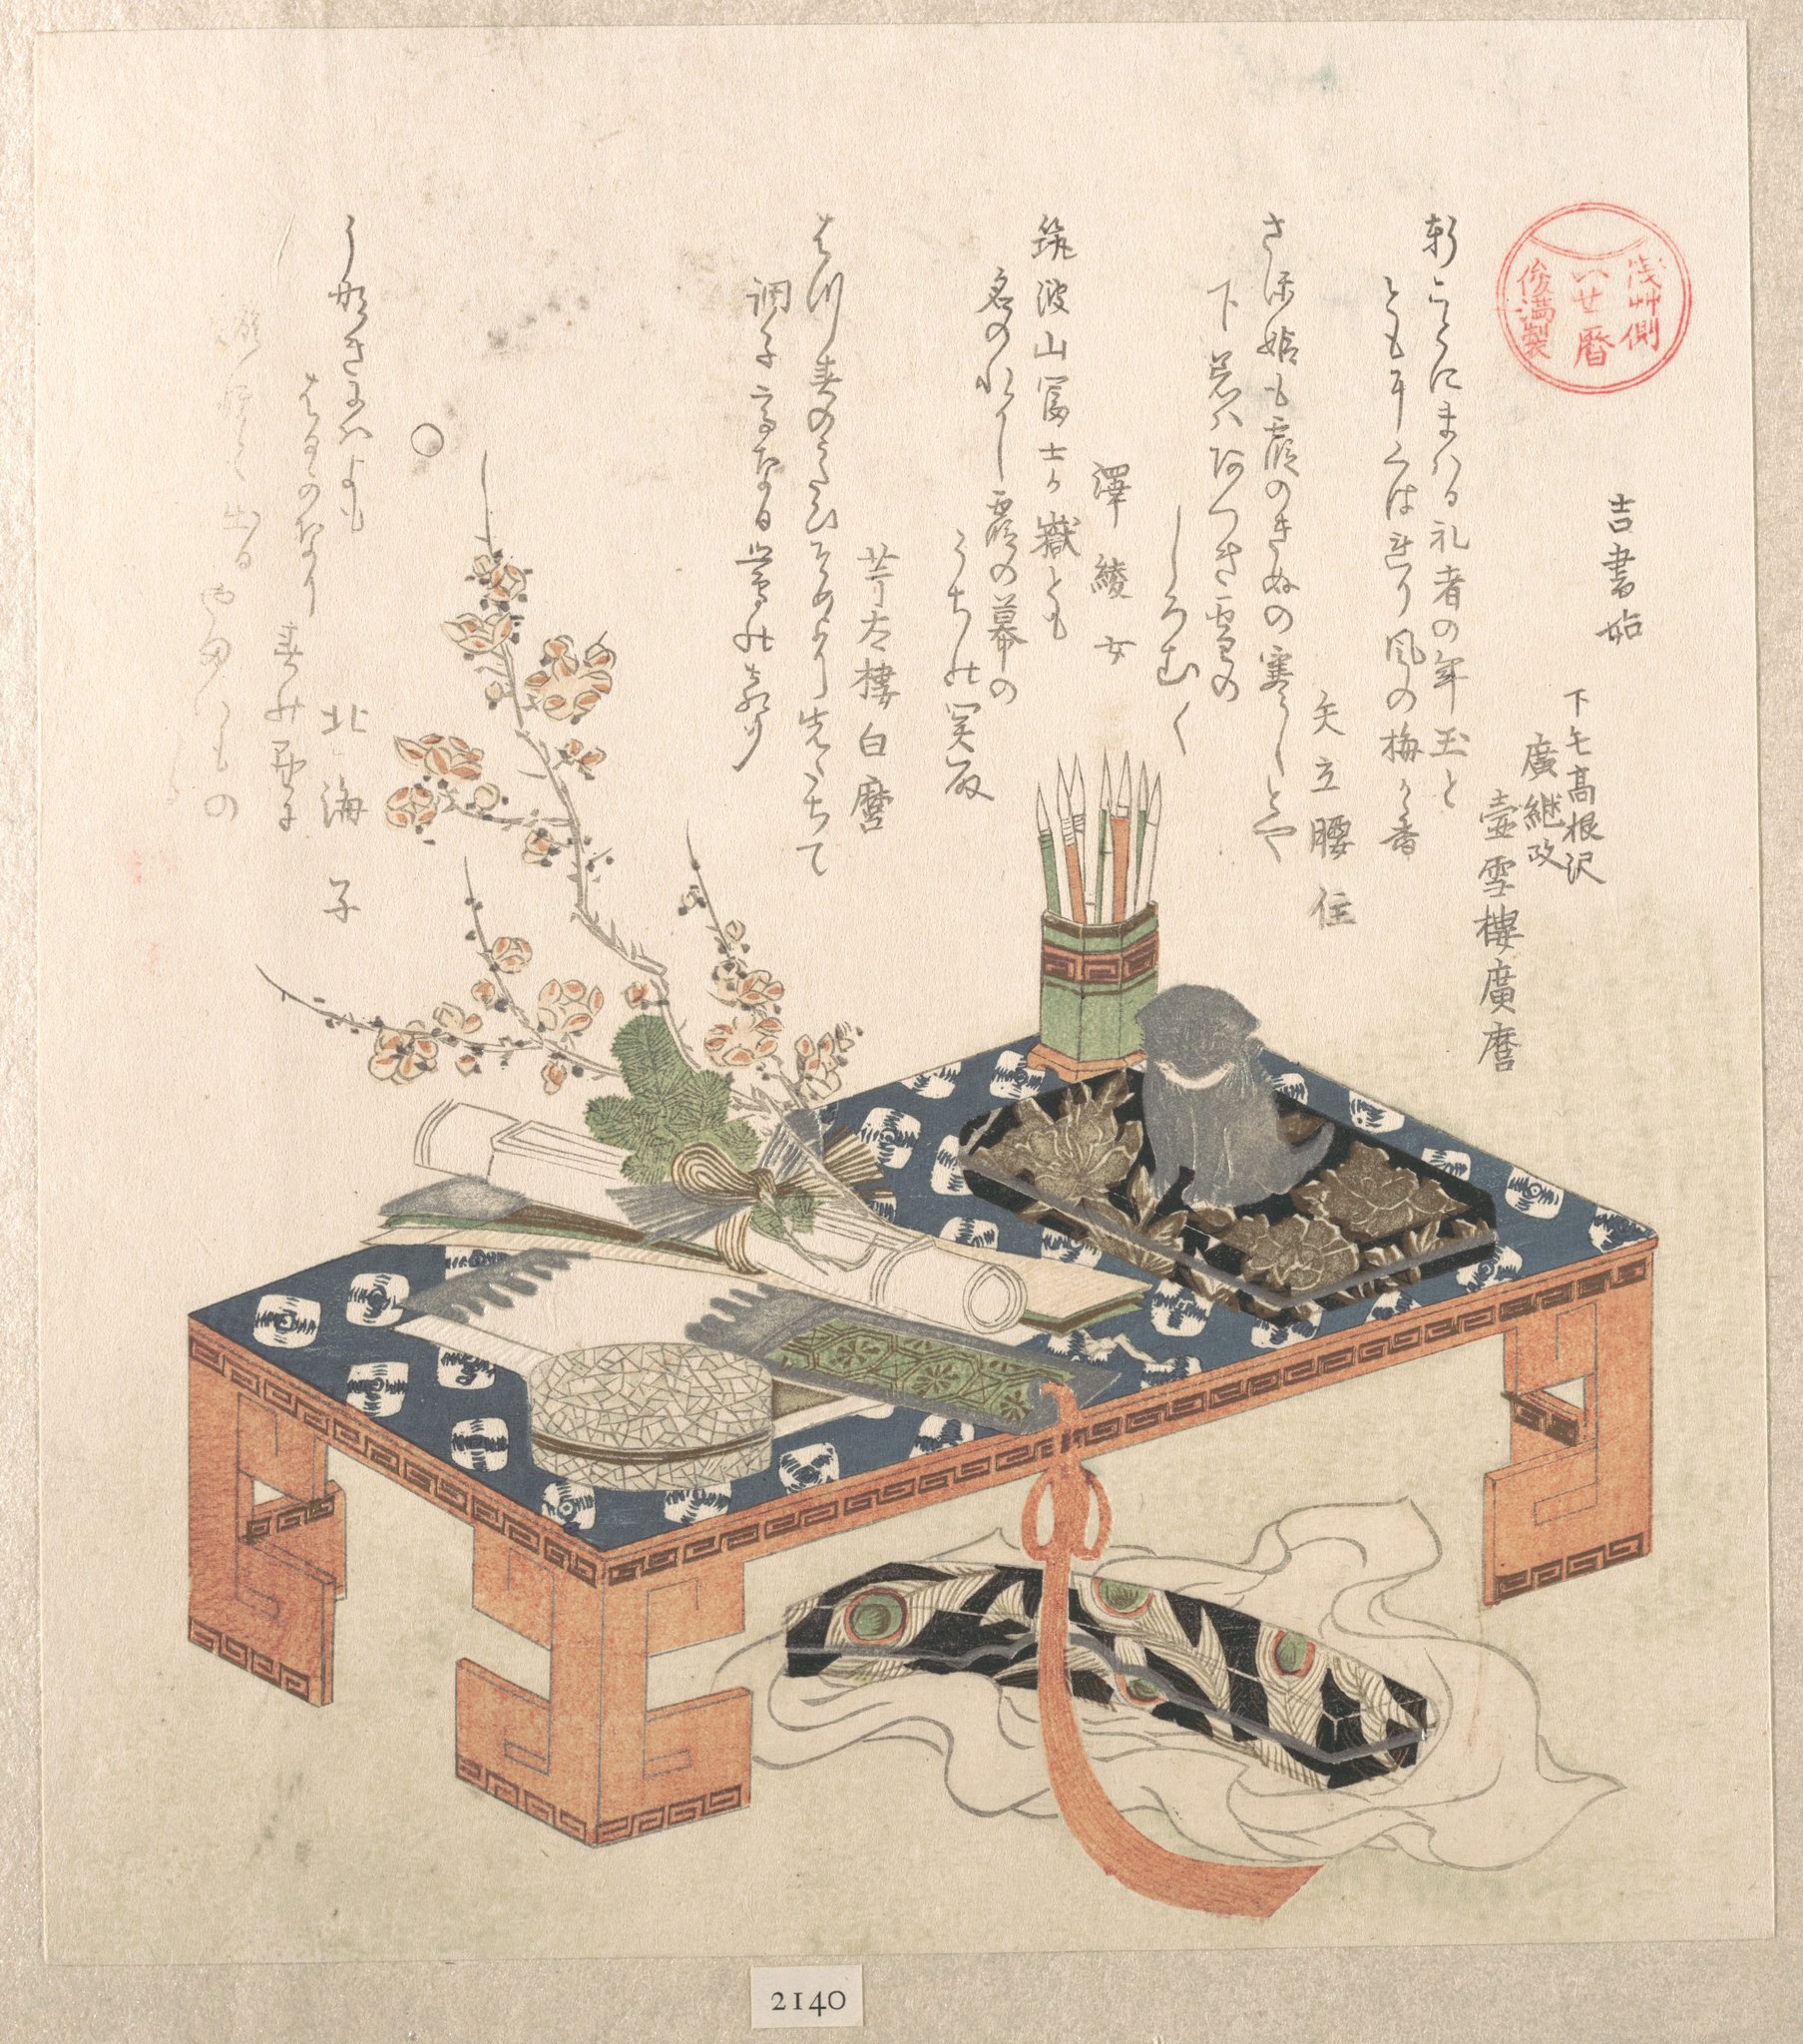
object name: print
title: “Desk with Writing Set and Plum Flowers,” from the series Ise Calendars for the Asakusa Group (Asakusa-gawa Ise goyomi) From the Spring Rain Collection (Harusame shū), vol. 2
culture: japanese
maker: kubo shunman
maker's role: artist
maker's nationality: japanese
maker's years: 1757-1820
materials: ink, paper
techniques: surimono, woodblock print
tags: animals,flowers,desks,brushes